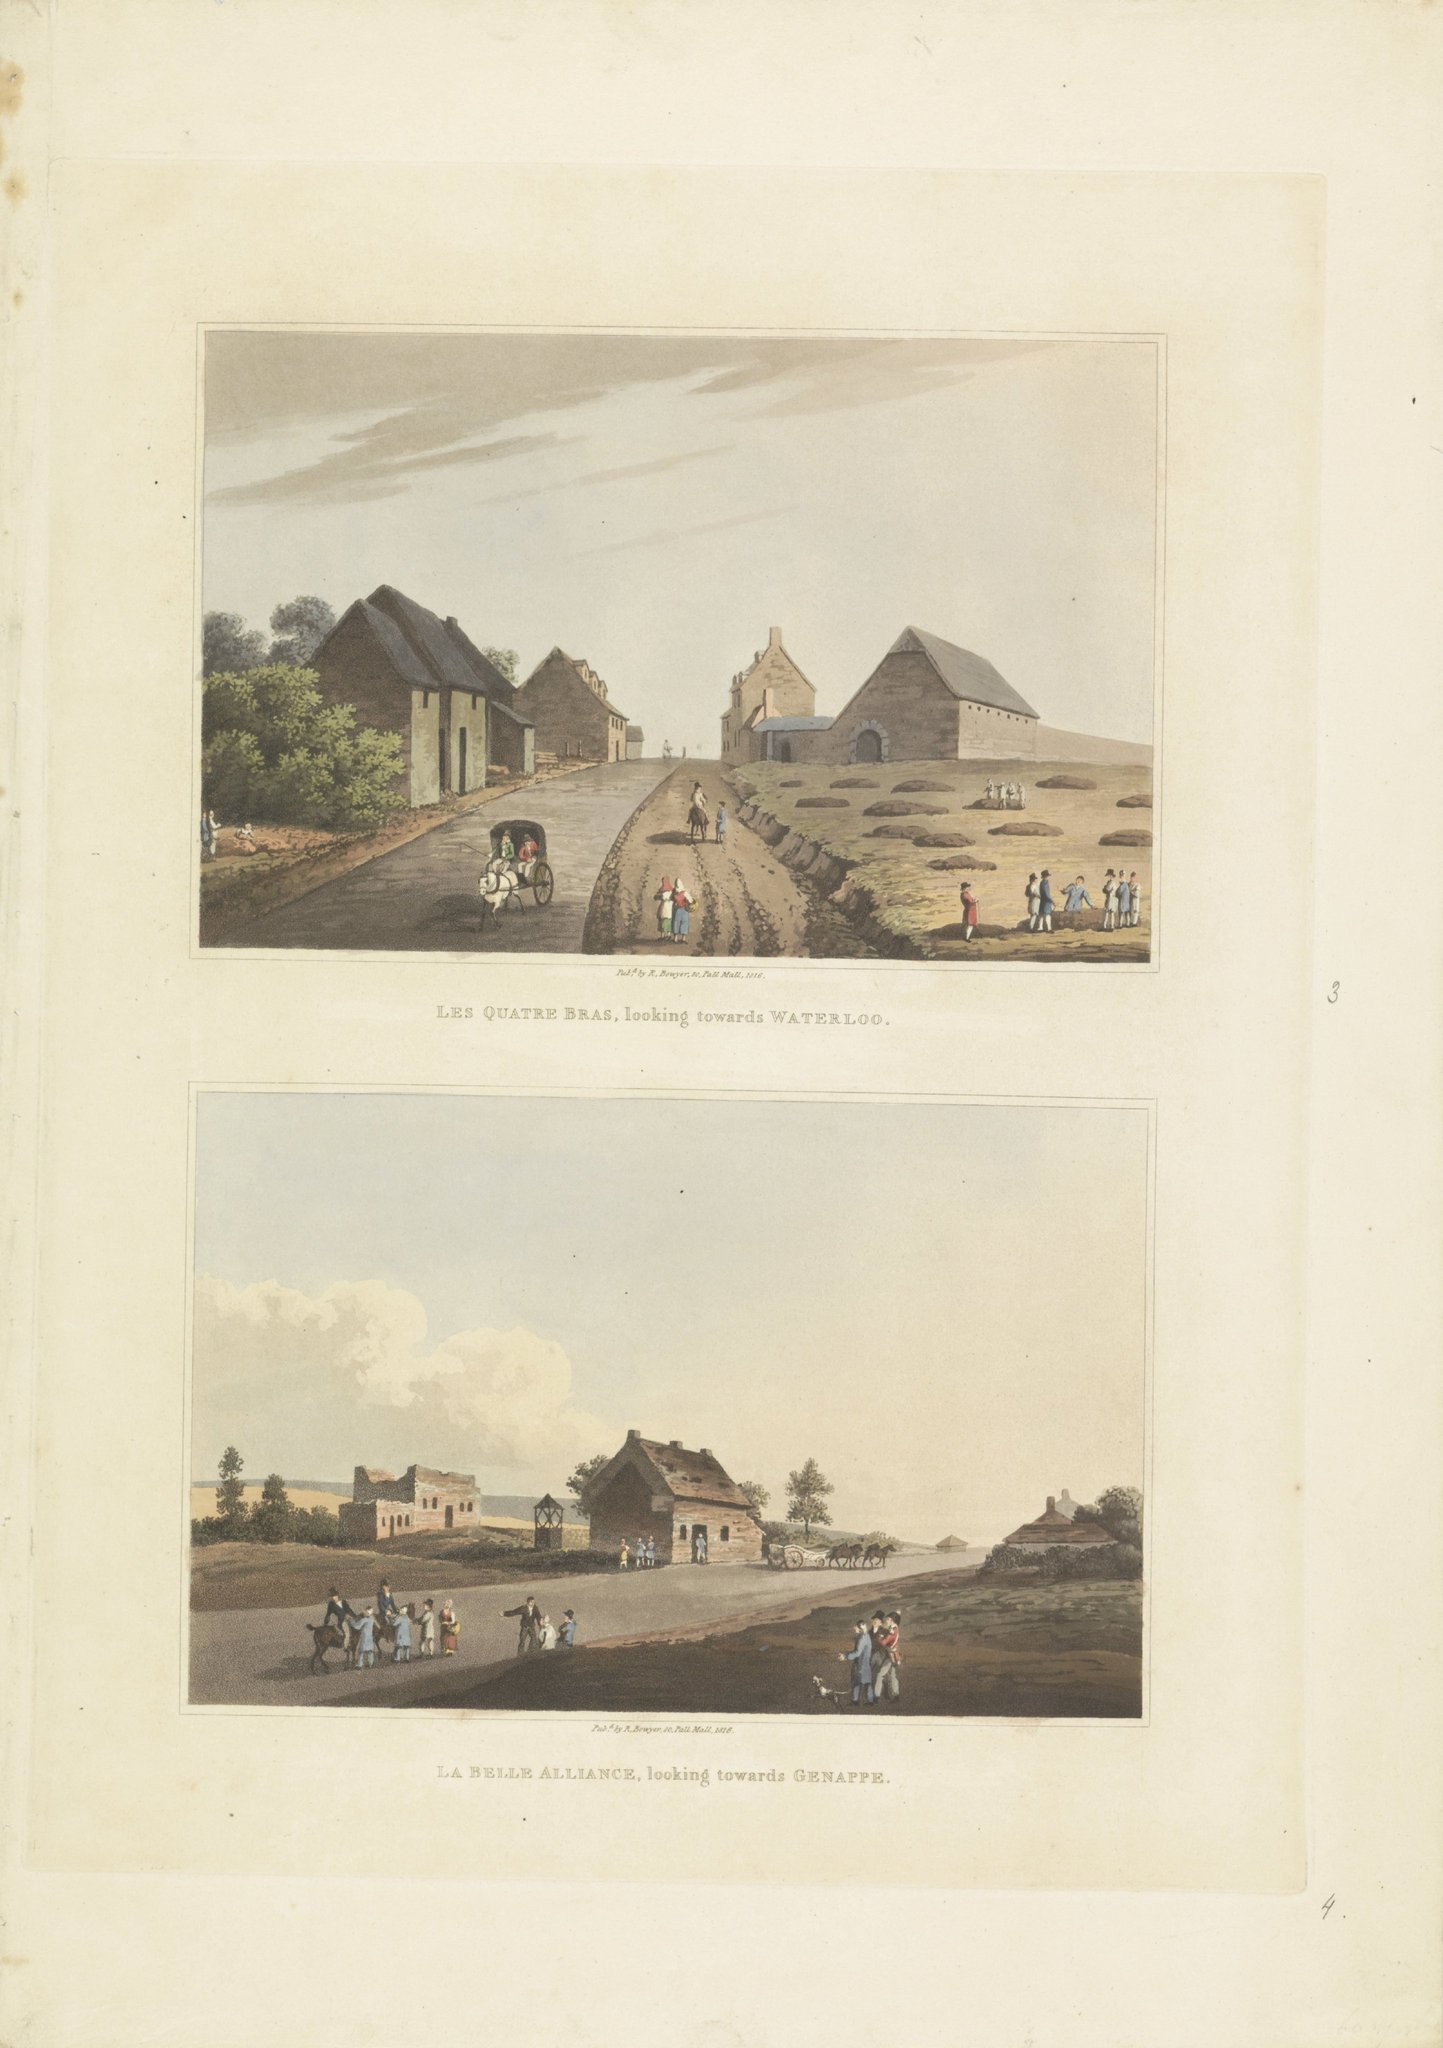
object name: print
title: Les Quatre-Bras en La Belle Alliance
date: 1816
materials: paper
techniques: aquatint, hand coloring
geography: london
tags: devastated, ruined place or city (~ warfare), grave, tomb and other grave-forms and grave-markers, waterloo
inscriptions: collector's mark: Lugt 2228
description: Gebruikt als illustratie in: T.H. Horne, The campaign of Waterloo, illustrated with engravings of Les Quatre Bras, La Belle Alliance, Hougoumont, La Haye Sainte, and other principal scenes of action; including a correct military plan. London, Printed by T. Bensley, for R. Bowyer, 1816.